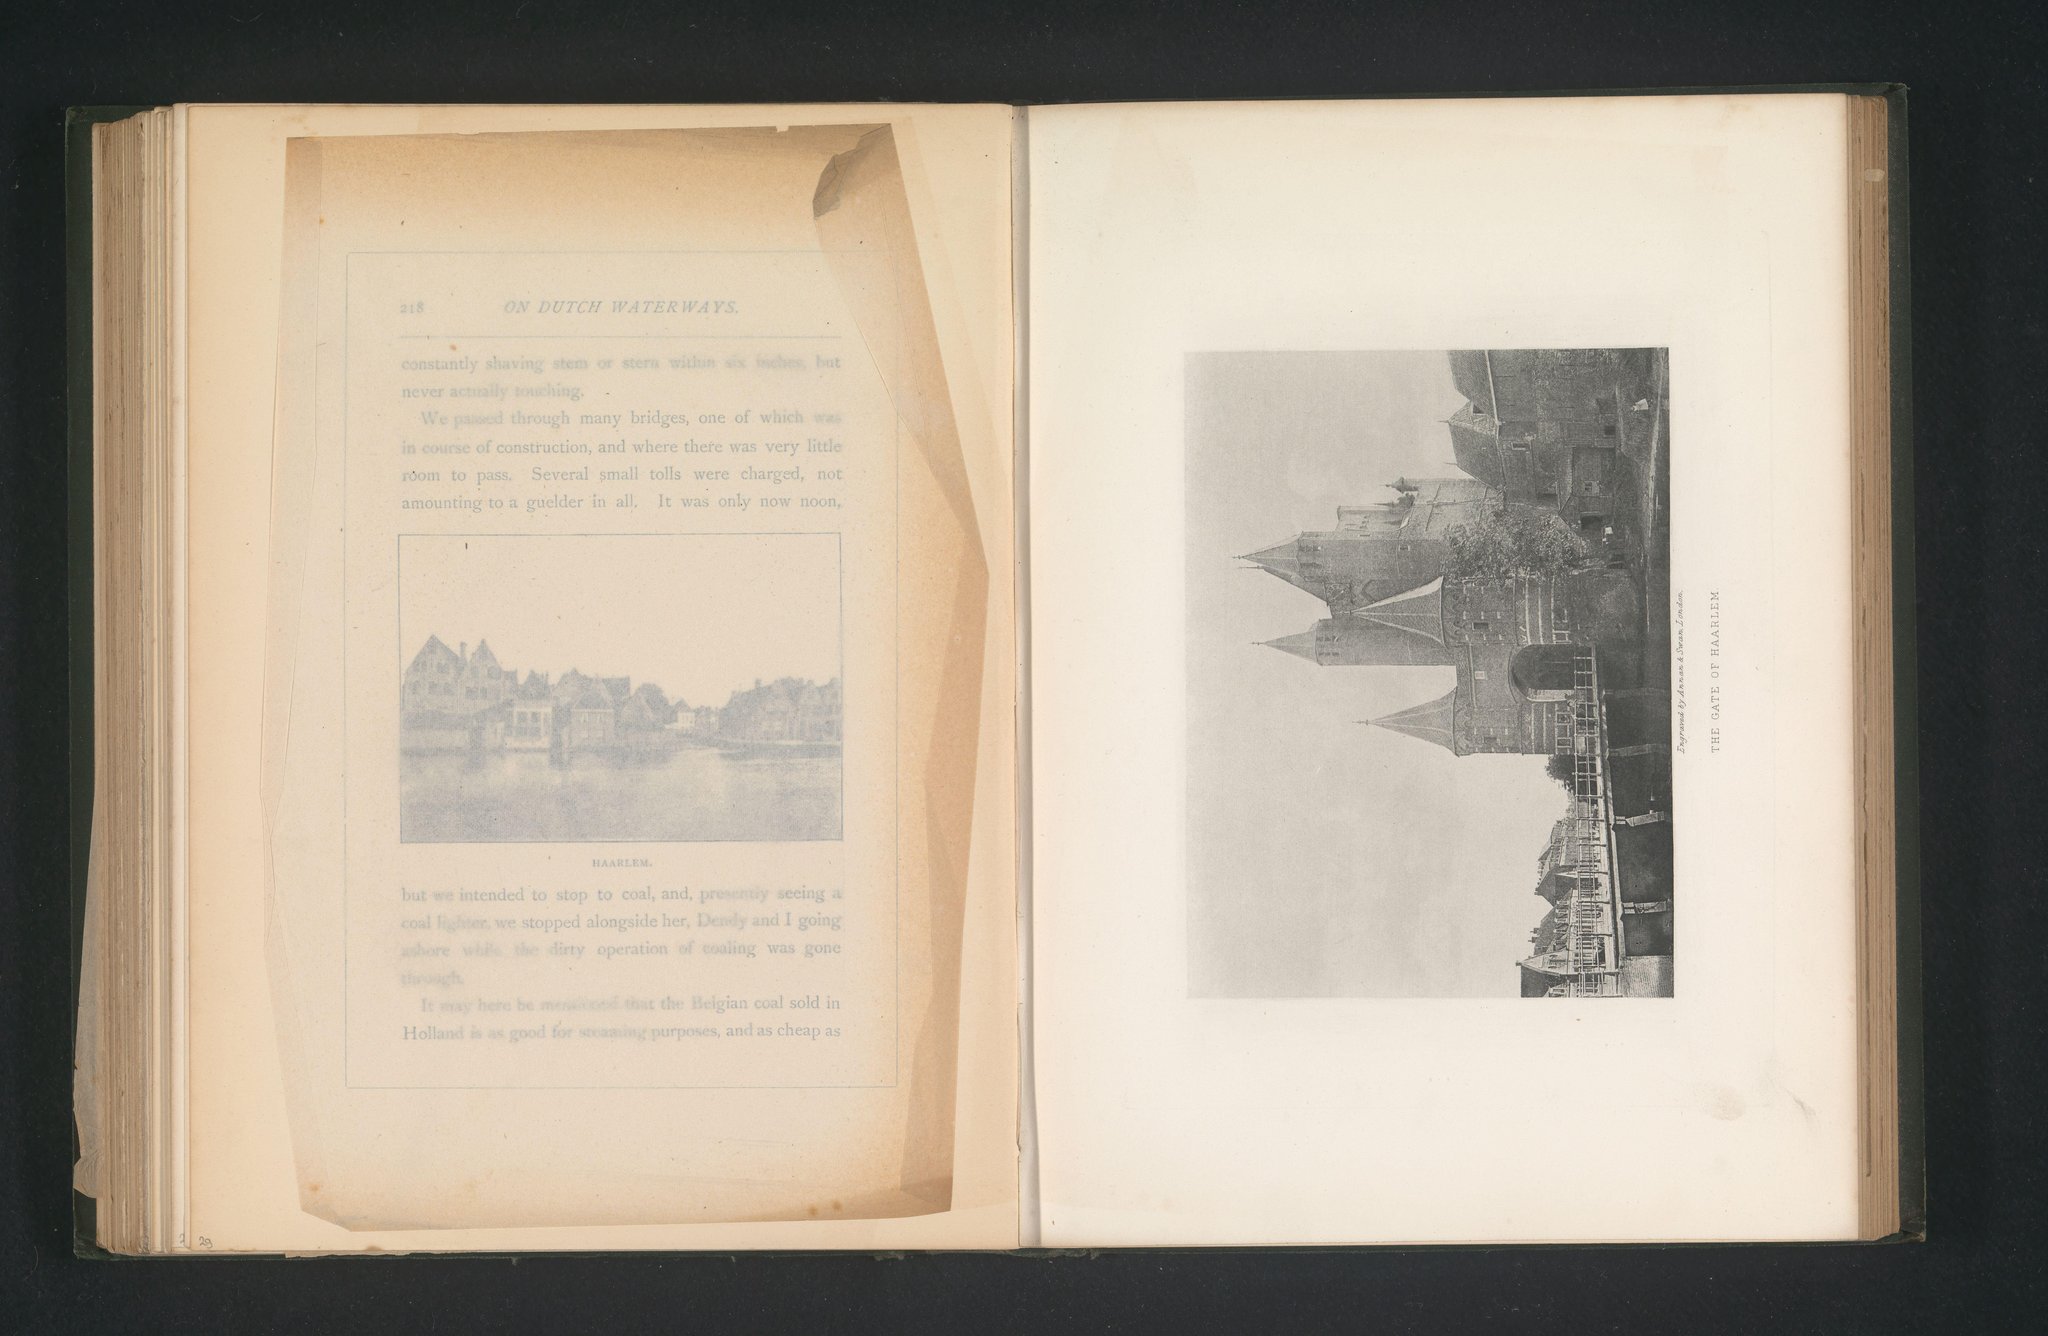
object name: photomechanical print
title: The Gate of Haarlem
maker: george christopher davies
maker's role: fotograaf, geoloog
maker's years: 1849-1922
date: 1881-1886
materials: paper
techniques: photoaquatint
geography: london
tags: city-gate